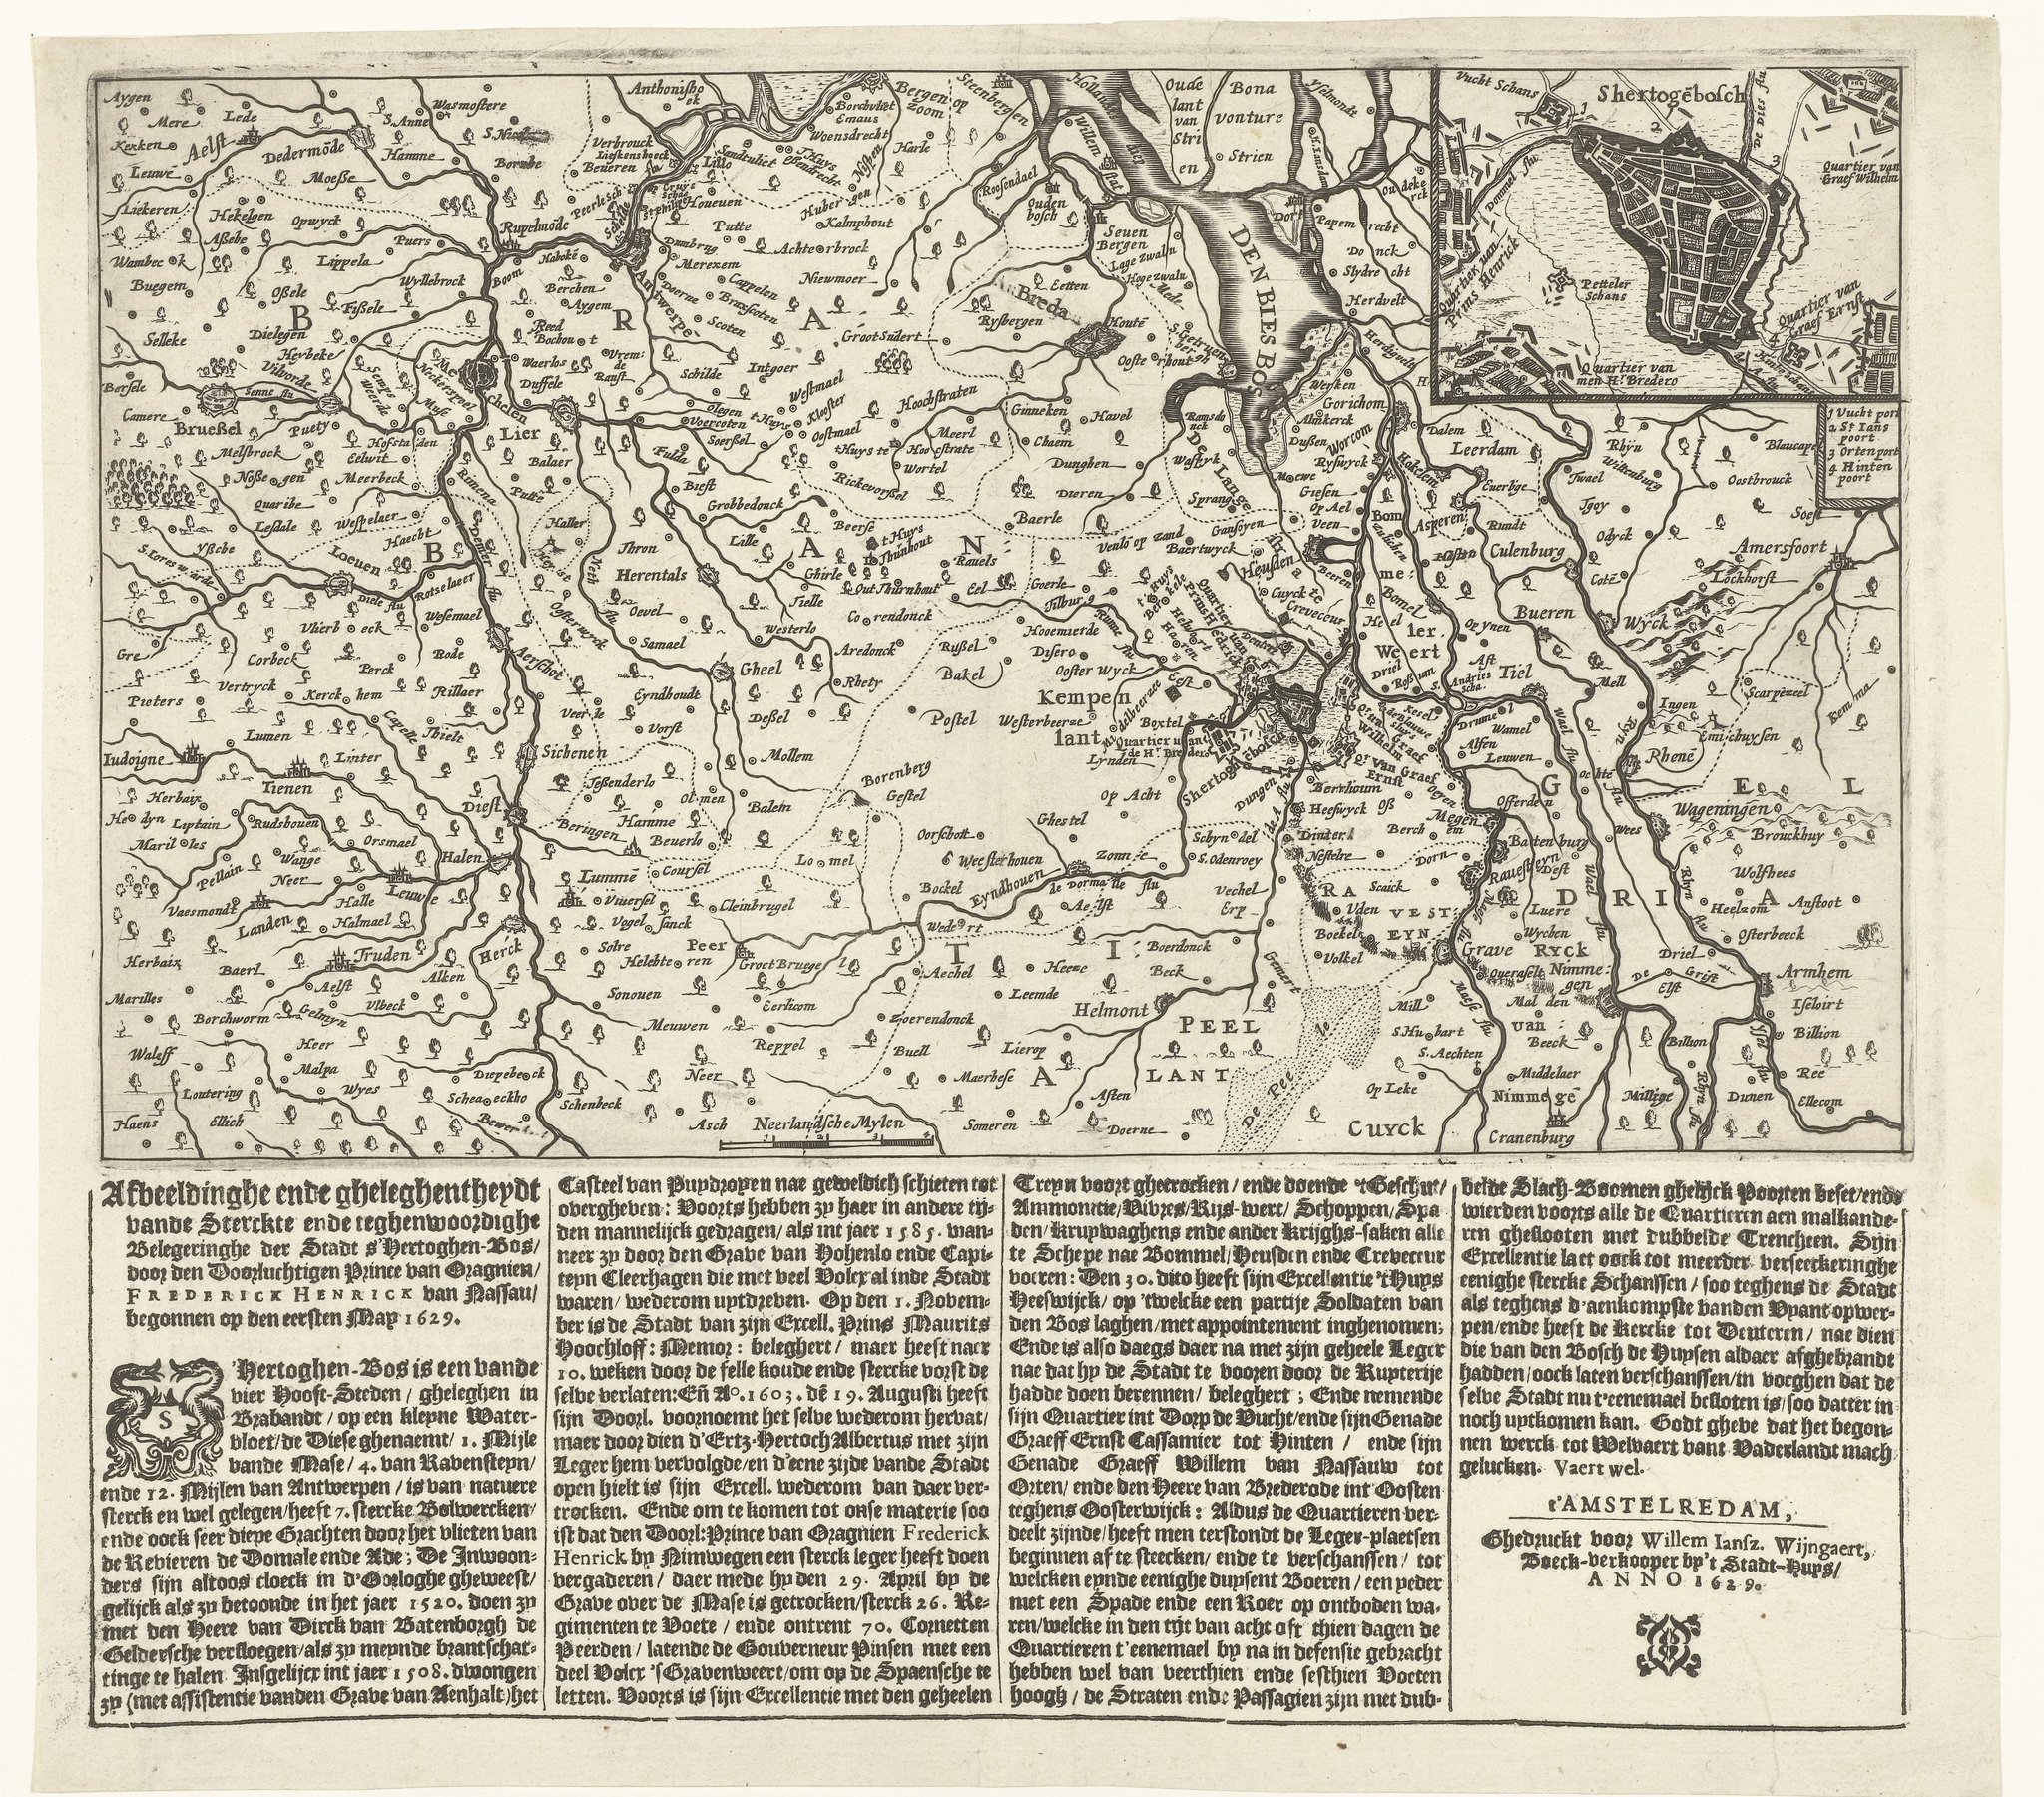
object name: print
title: Kaart van Noord-Brabant met het beleg van Den Bosch, 1629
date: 1629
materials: paper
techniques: etching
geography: amsterdam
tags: delft, the hague, frederick henry (prince of orange), maps of separate countries or regions, siege, position war, maps of cities, den bosch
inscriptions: date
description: Kaart van een groot deel van Noord-Brabant van Antwerpen tot Nijmegen met het beleg van Den Bosch door het Staatse leger onder Frederik Hendrik, van 1 mei tot 17 september 1629. Rechtsboven een inzet met een plattegrond van de stad. Gedrukt onder de plaat 4 kolommen tekst in het Nederlands.